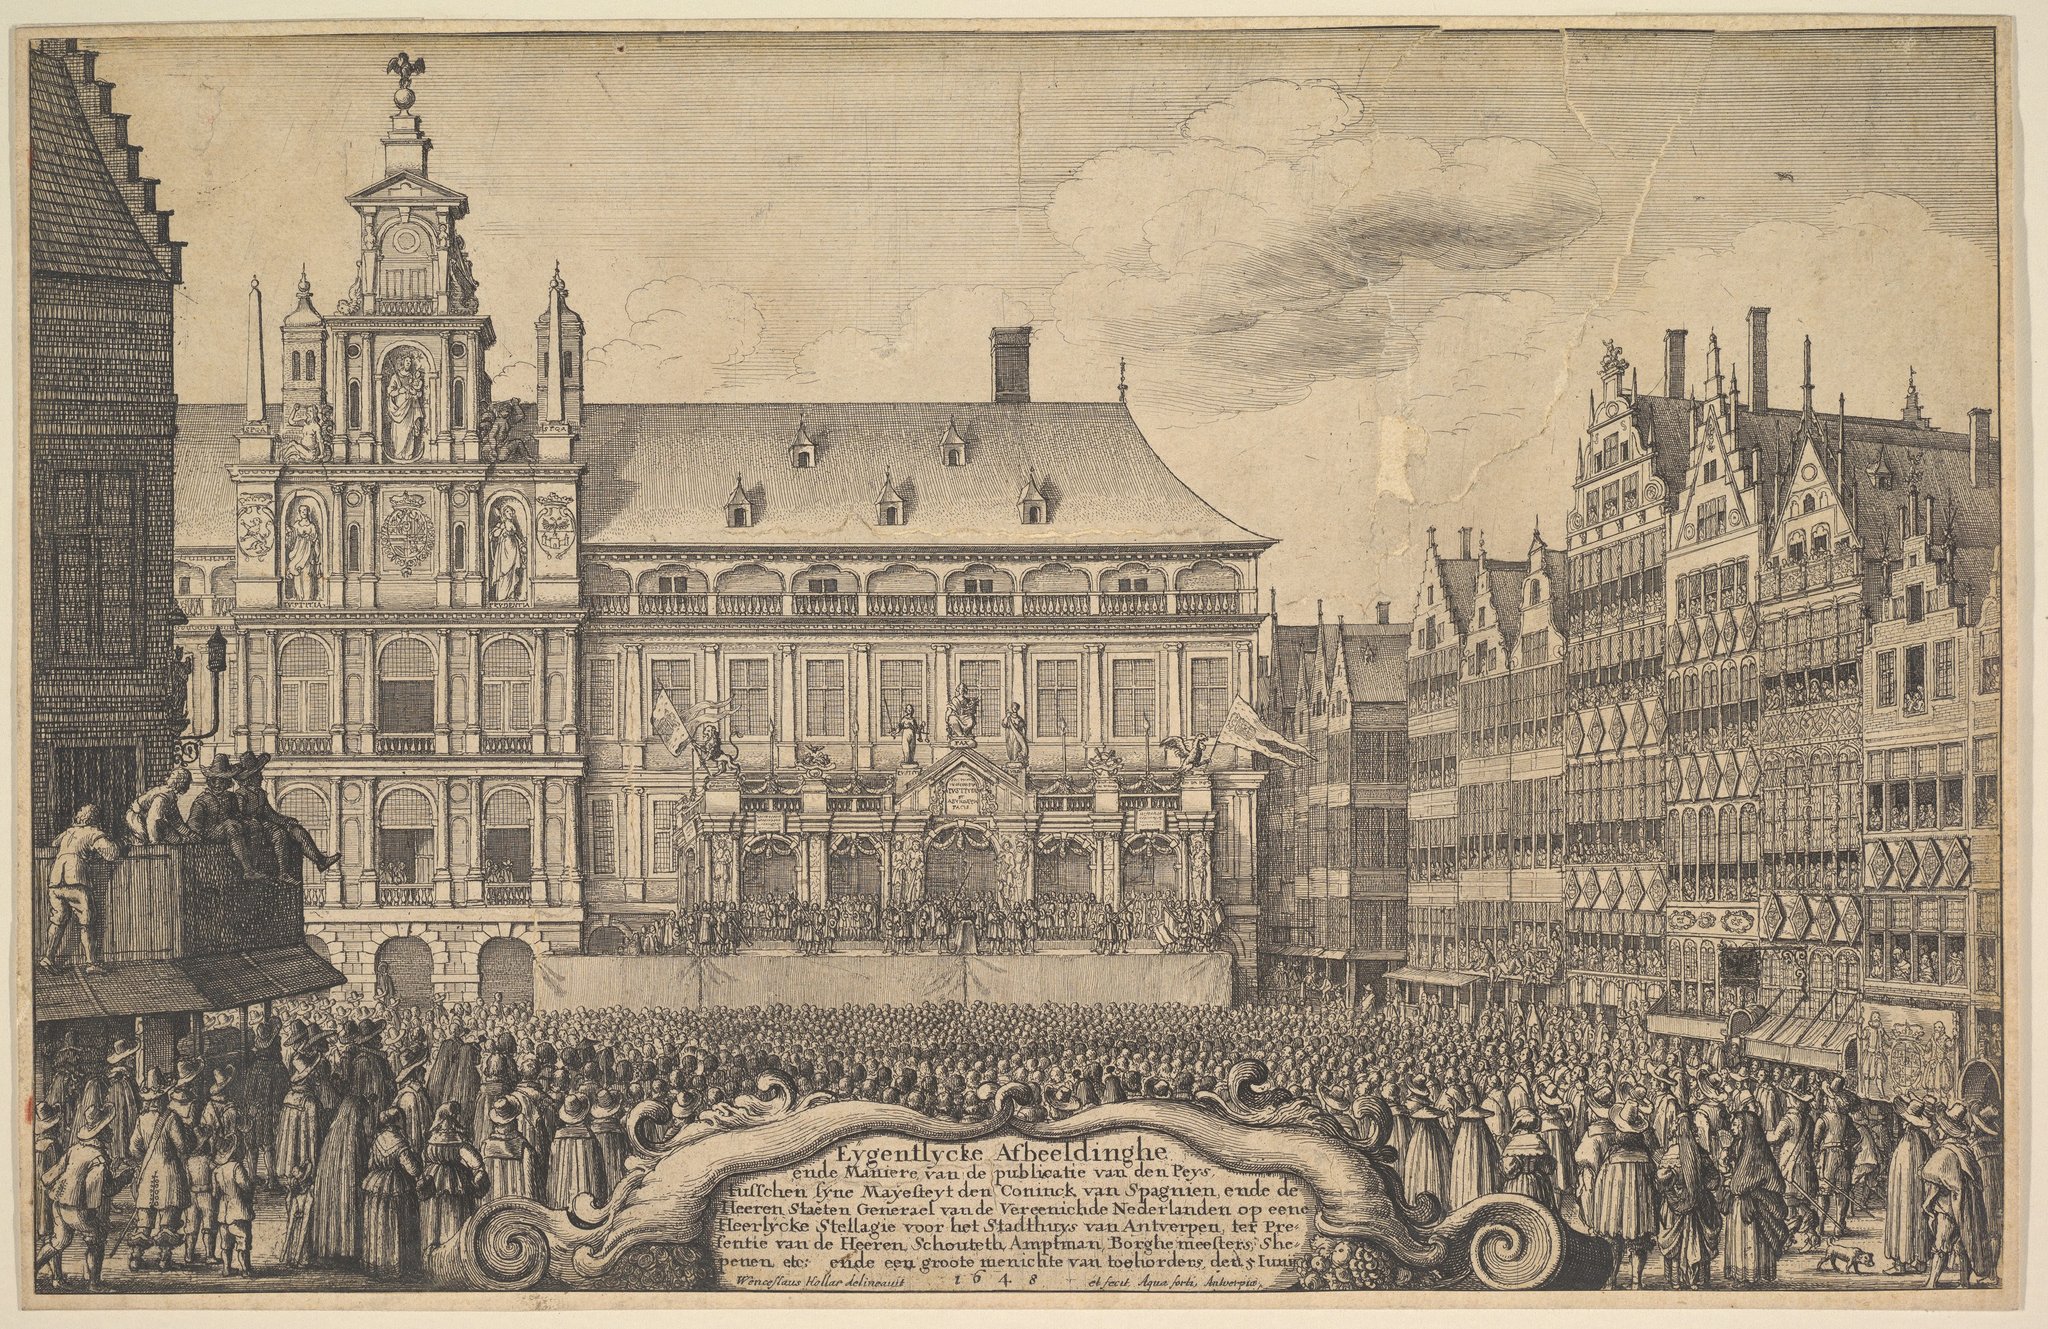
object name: print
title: Proclamation of the Treaty of Munster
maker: wenceslaus hollar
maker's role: artist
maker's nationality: bohemian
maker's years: 1607-1677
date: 1648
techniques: etching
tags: buildings,crowd,coat of arms,flags